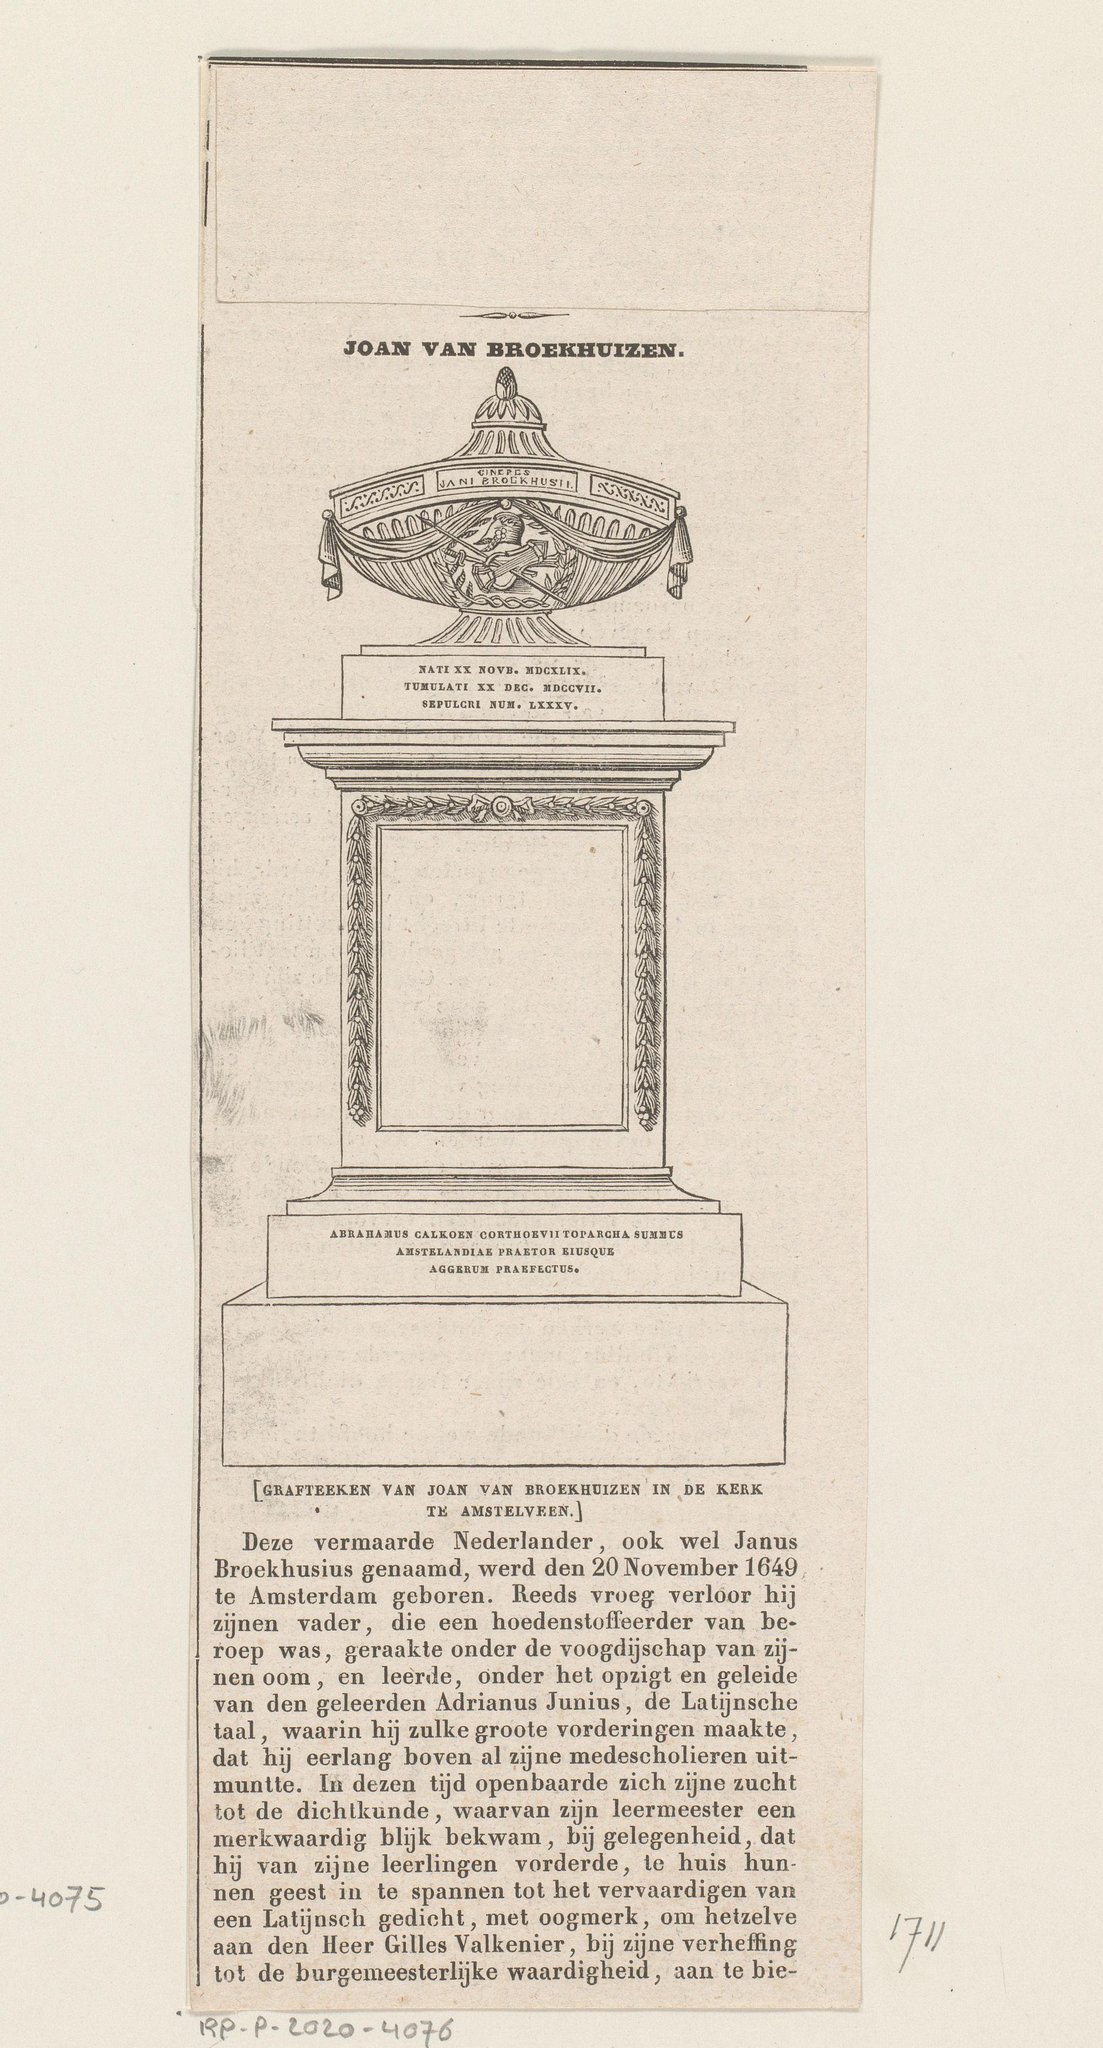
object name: print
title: Grafmonument van Joan van Broekhuizen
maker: Anonymous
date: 1836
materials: paper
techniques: letterpress printing, engraving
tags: amsterdam, joan van broekhuizen, grave-building, monumental tomb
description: Prent uit: Nederlandsch magazijn ter verspreiding van algemeene en nuttige kundigheden (1836), nr. 1, p. 5.